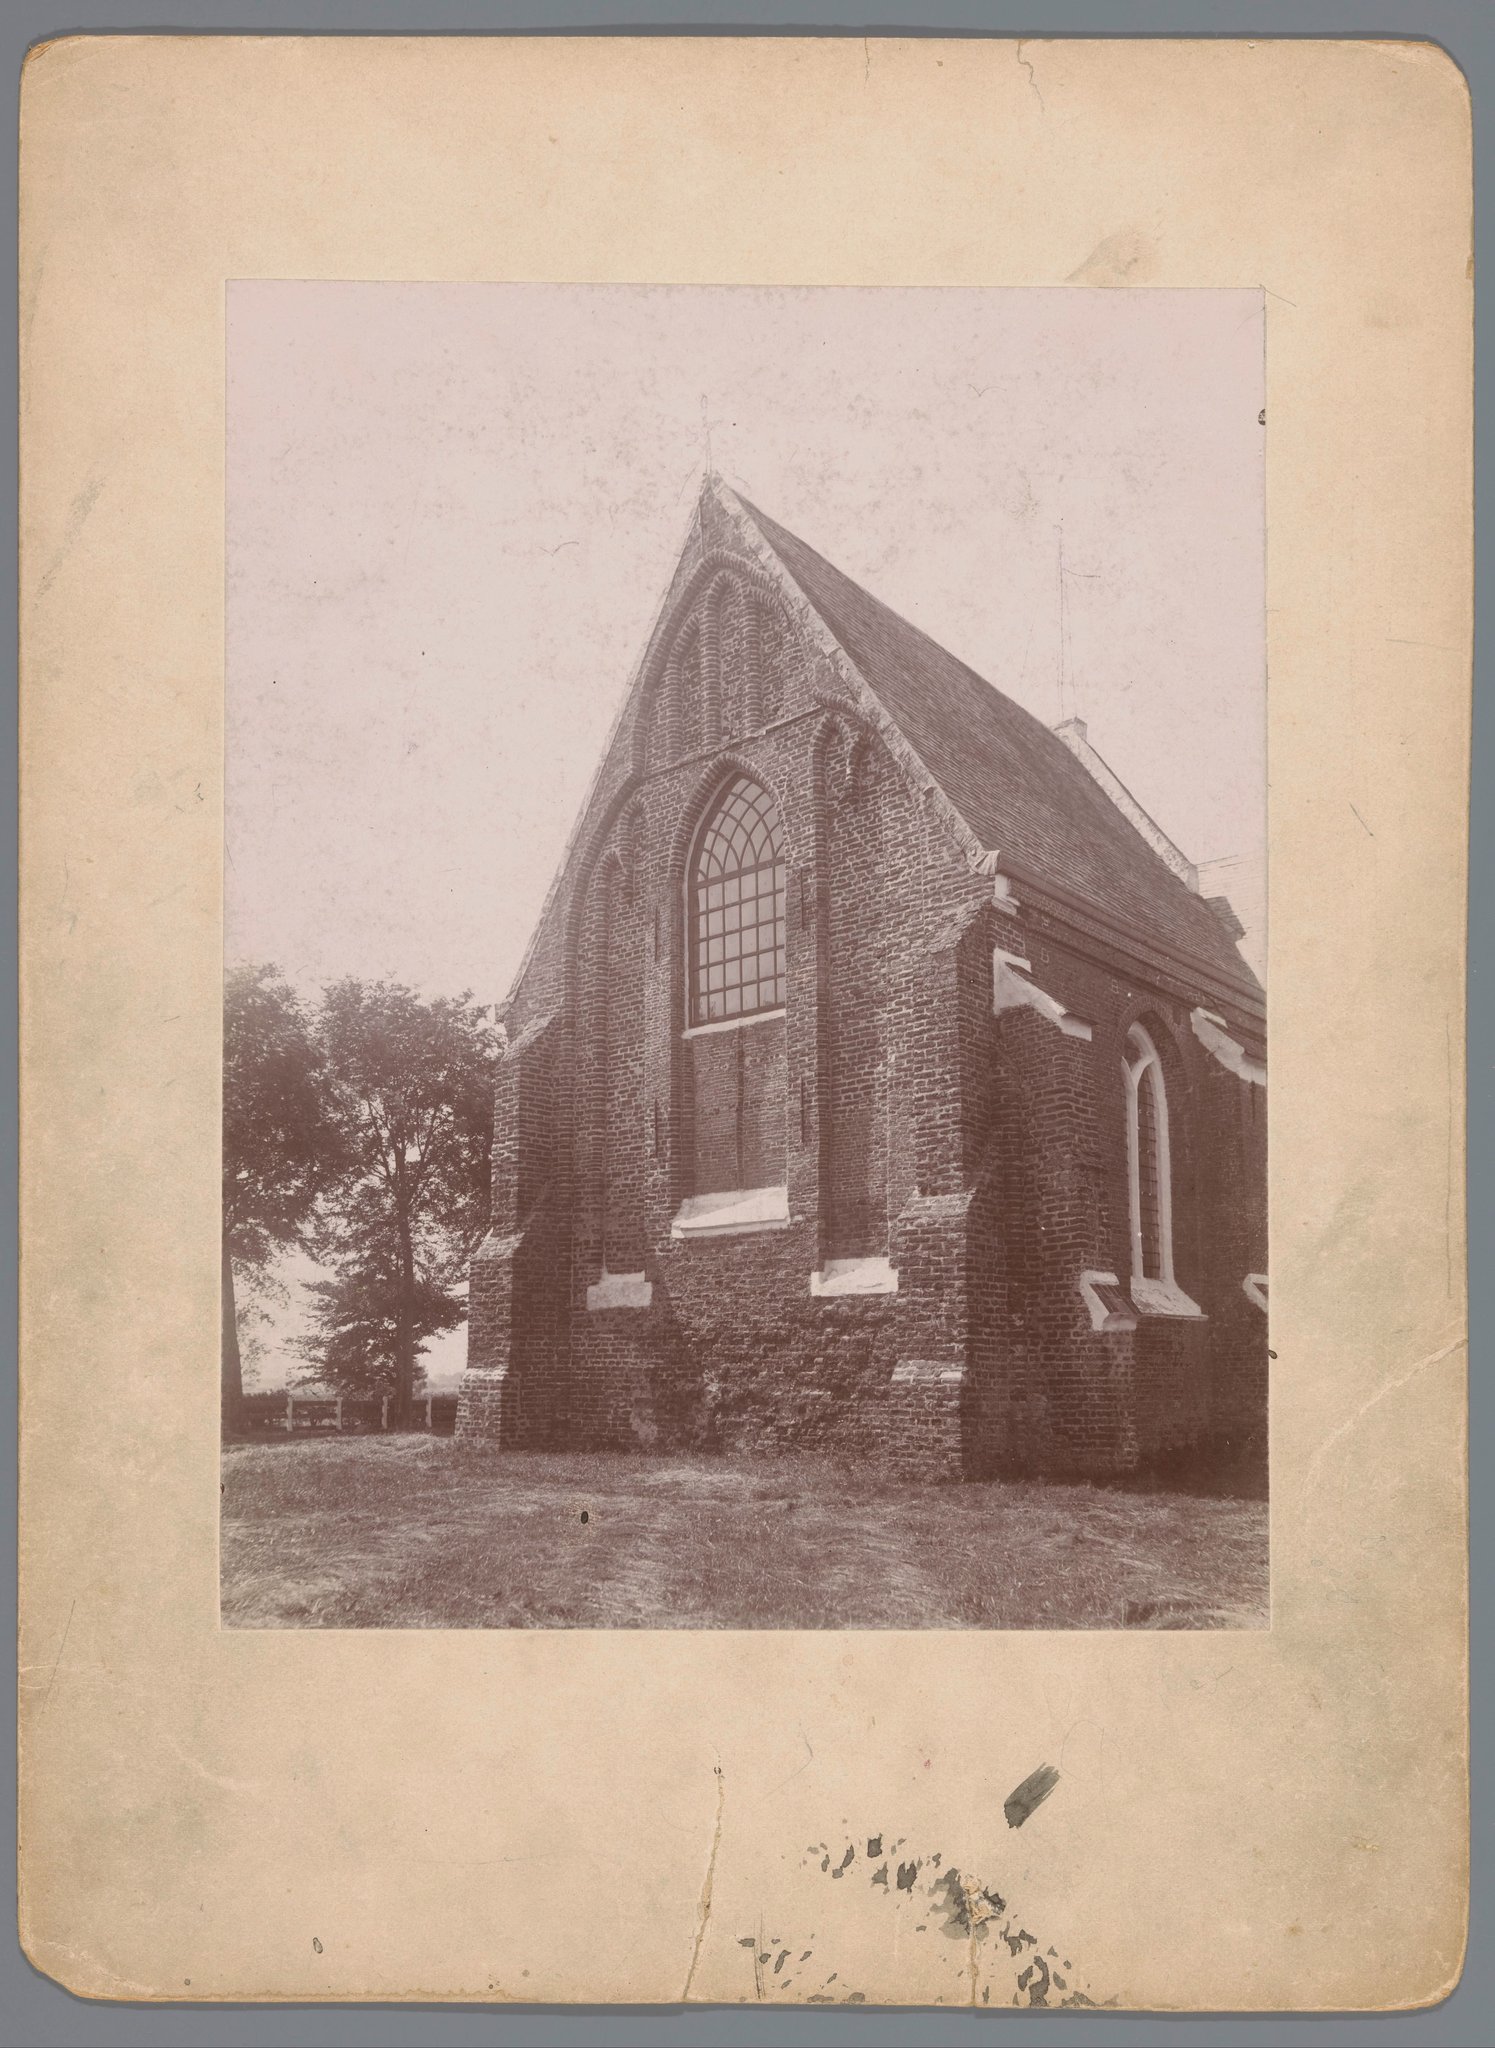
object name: photograph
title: Exterieur van een Nederlands-Hervormde kerk in Nederland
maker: Anonymous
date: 1875-1900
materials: cardboard, photographic support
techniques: daylight paper print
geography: netherlands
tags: parts of church exterior and annexes, netherlands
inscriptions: inscription: ‘[...] Koor der N.H kerk’, collector's mark: Lugt 3937, annotation: